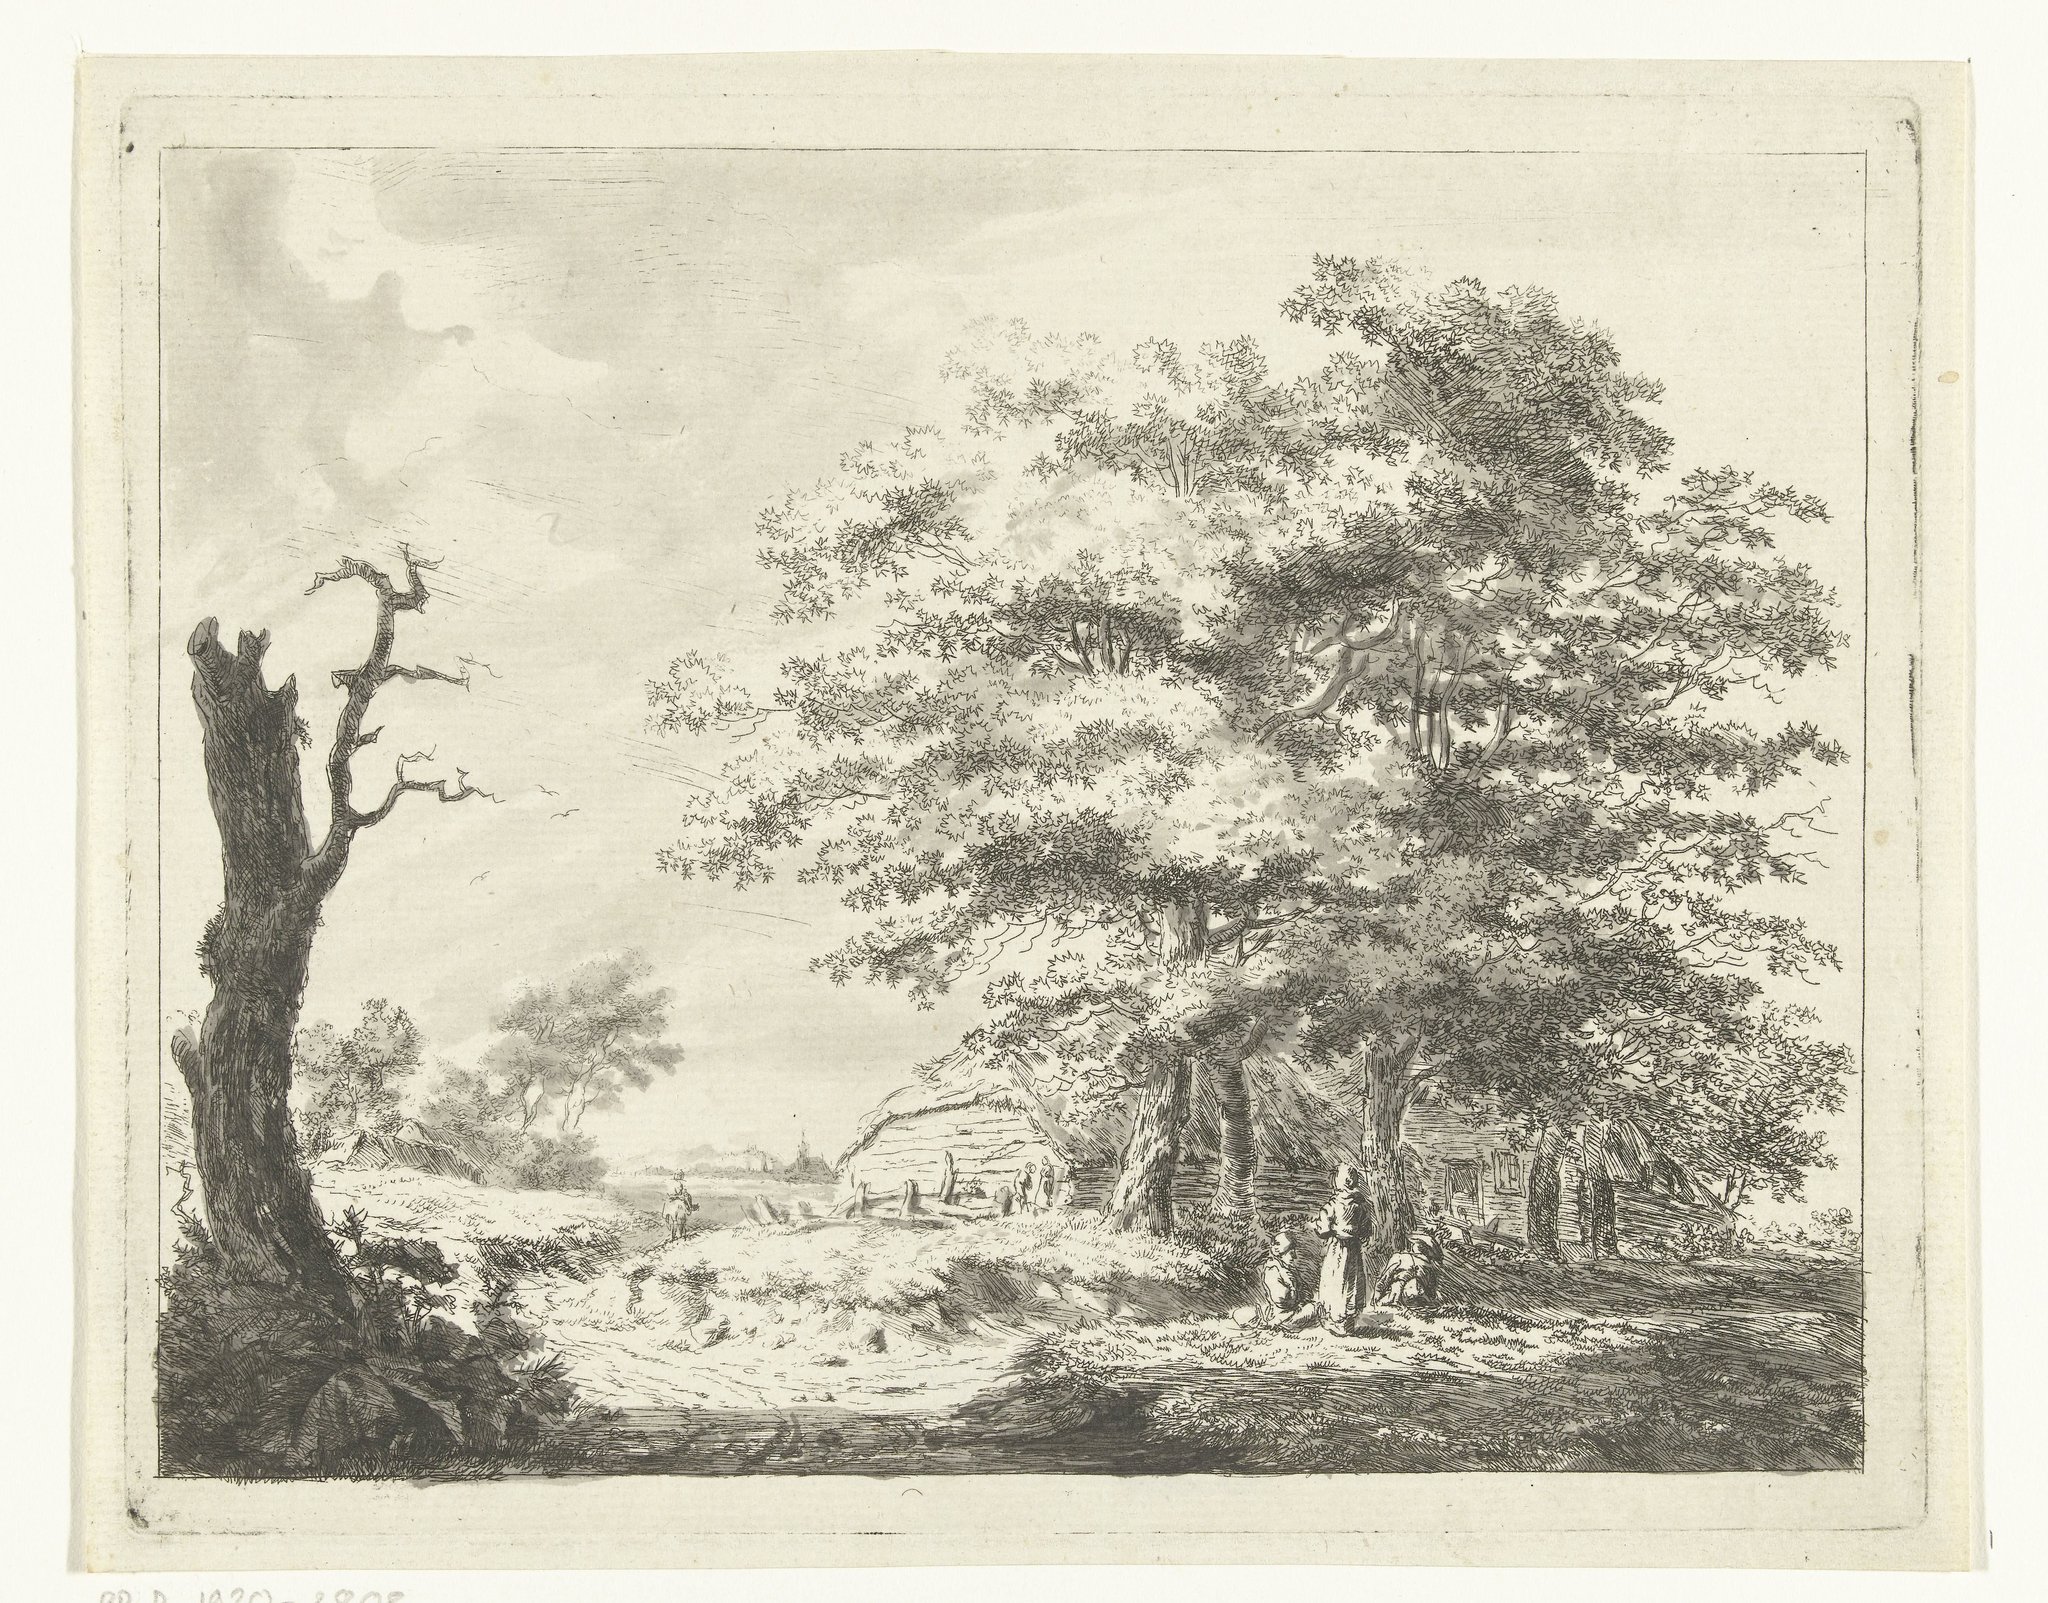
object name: print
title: Landschap met boerderij en figuren onder bomen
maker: hermanus van brussel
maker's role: draughtsman, print maker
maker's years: 1763-1815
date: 1800-1815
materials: paper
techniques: brush, etching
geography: netherlands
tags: landscapes in the temperate zone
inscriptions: collector's mark: Lugt 2228